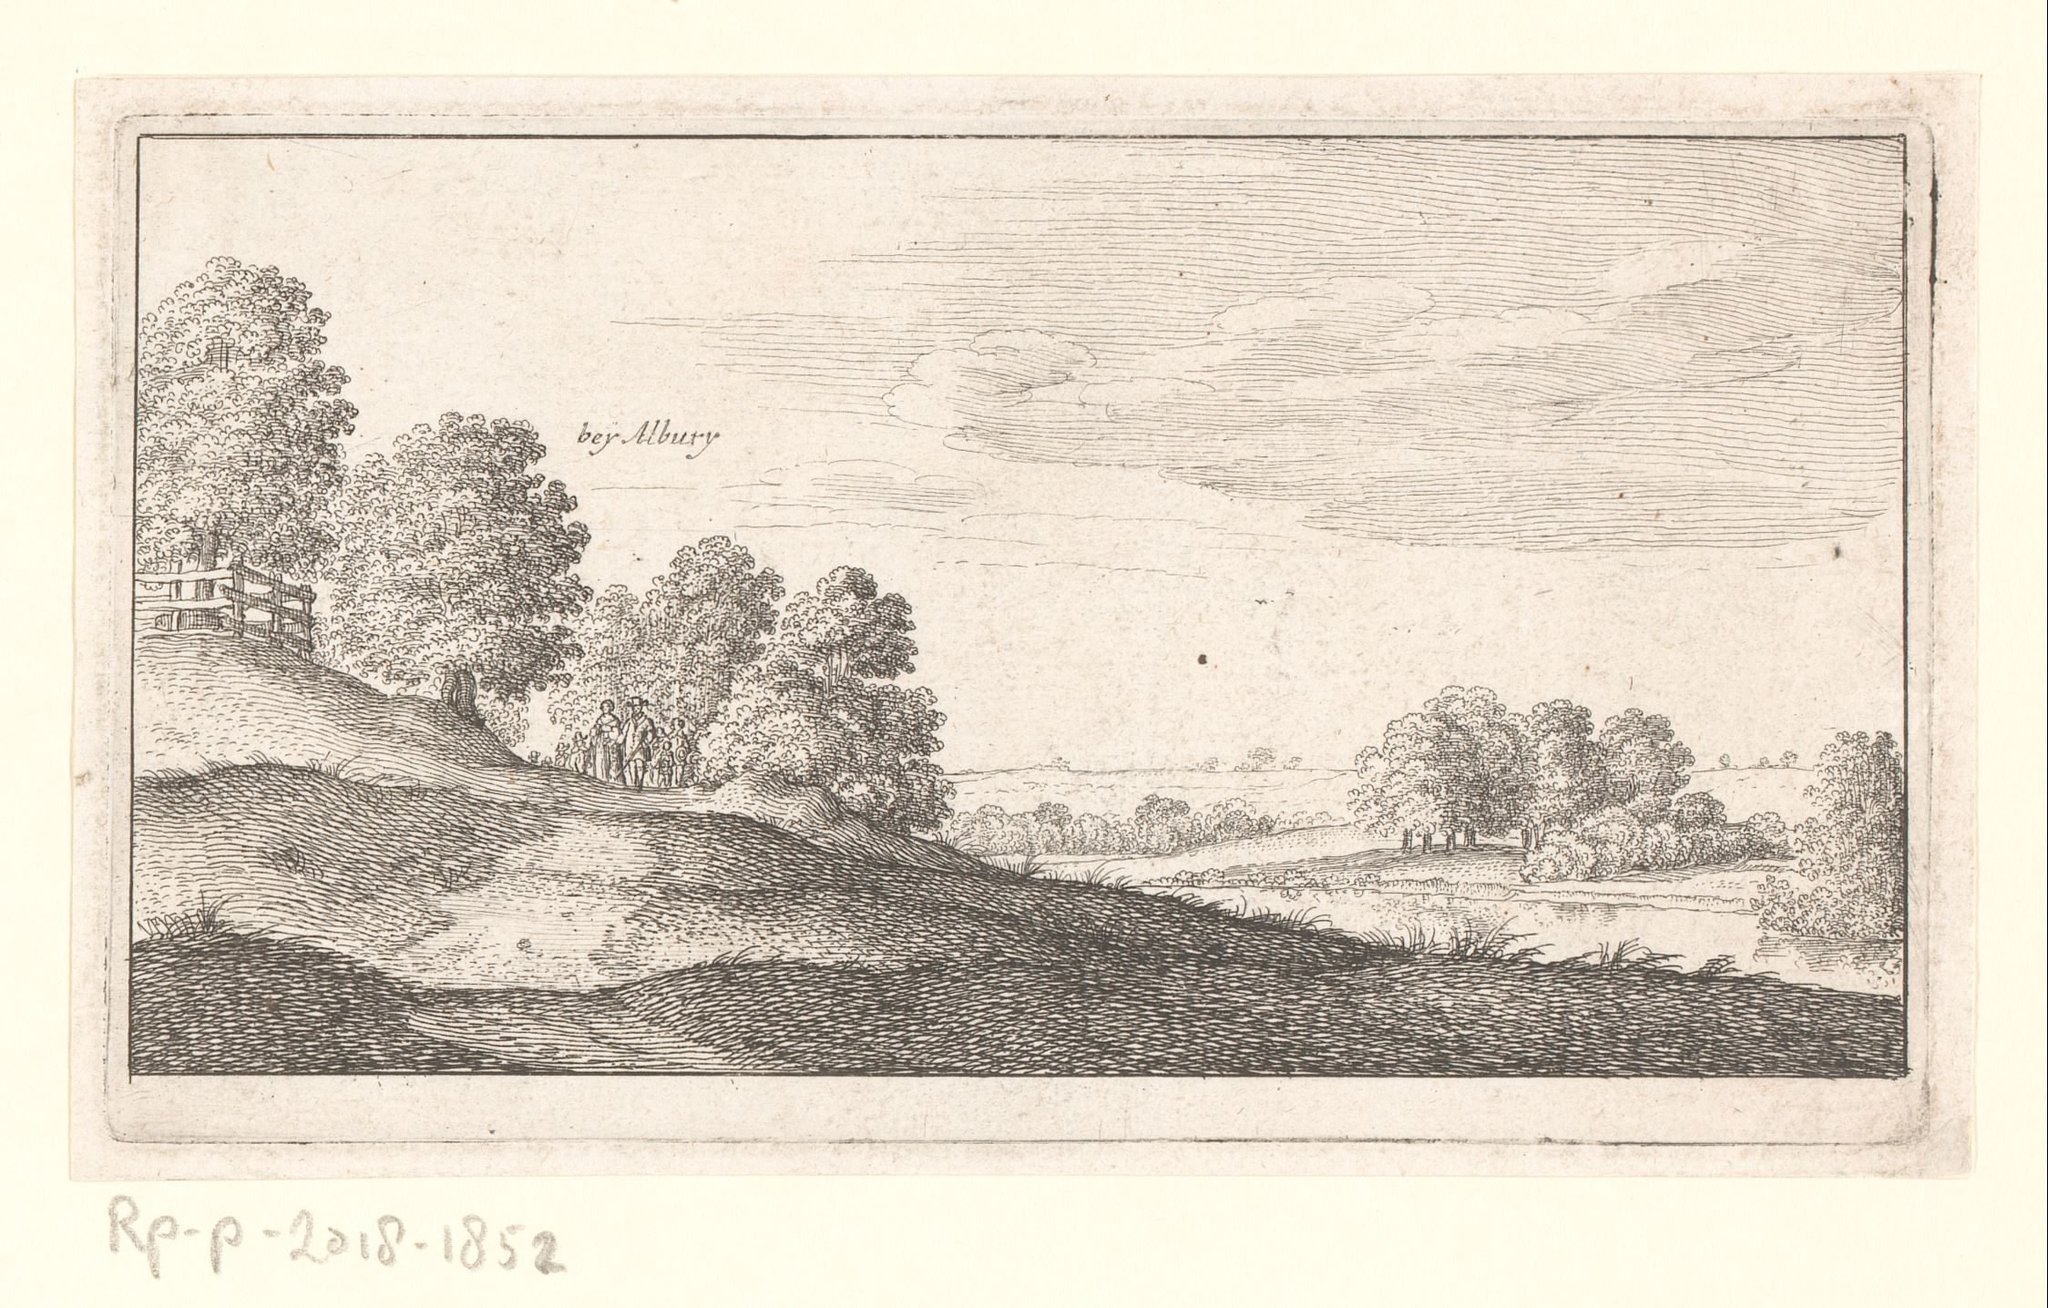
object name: print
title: bey Albury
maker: wenceslaus hollar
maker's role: draughtsman, print maker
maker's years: 1607-1677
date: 1645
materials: paper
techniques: etching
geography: antwerp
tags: landscapes with waters, waterscapes, seascapes (in the temperate zone)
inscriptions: collector's mark: Lugt 2228, collector's mark: Lugt 240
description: De prent maakt deel uit van een zesdelige serie met gezichten in de omgeving van Albury, Surrey.